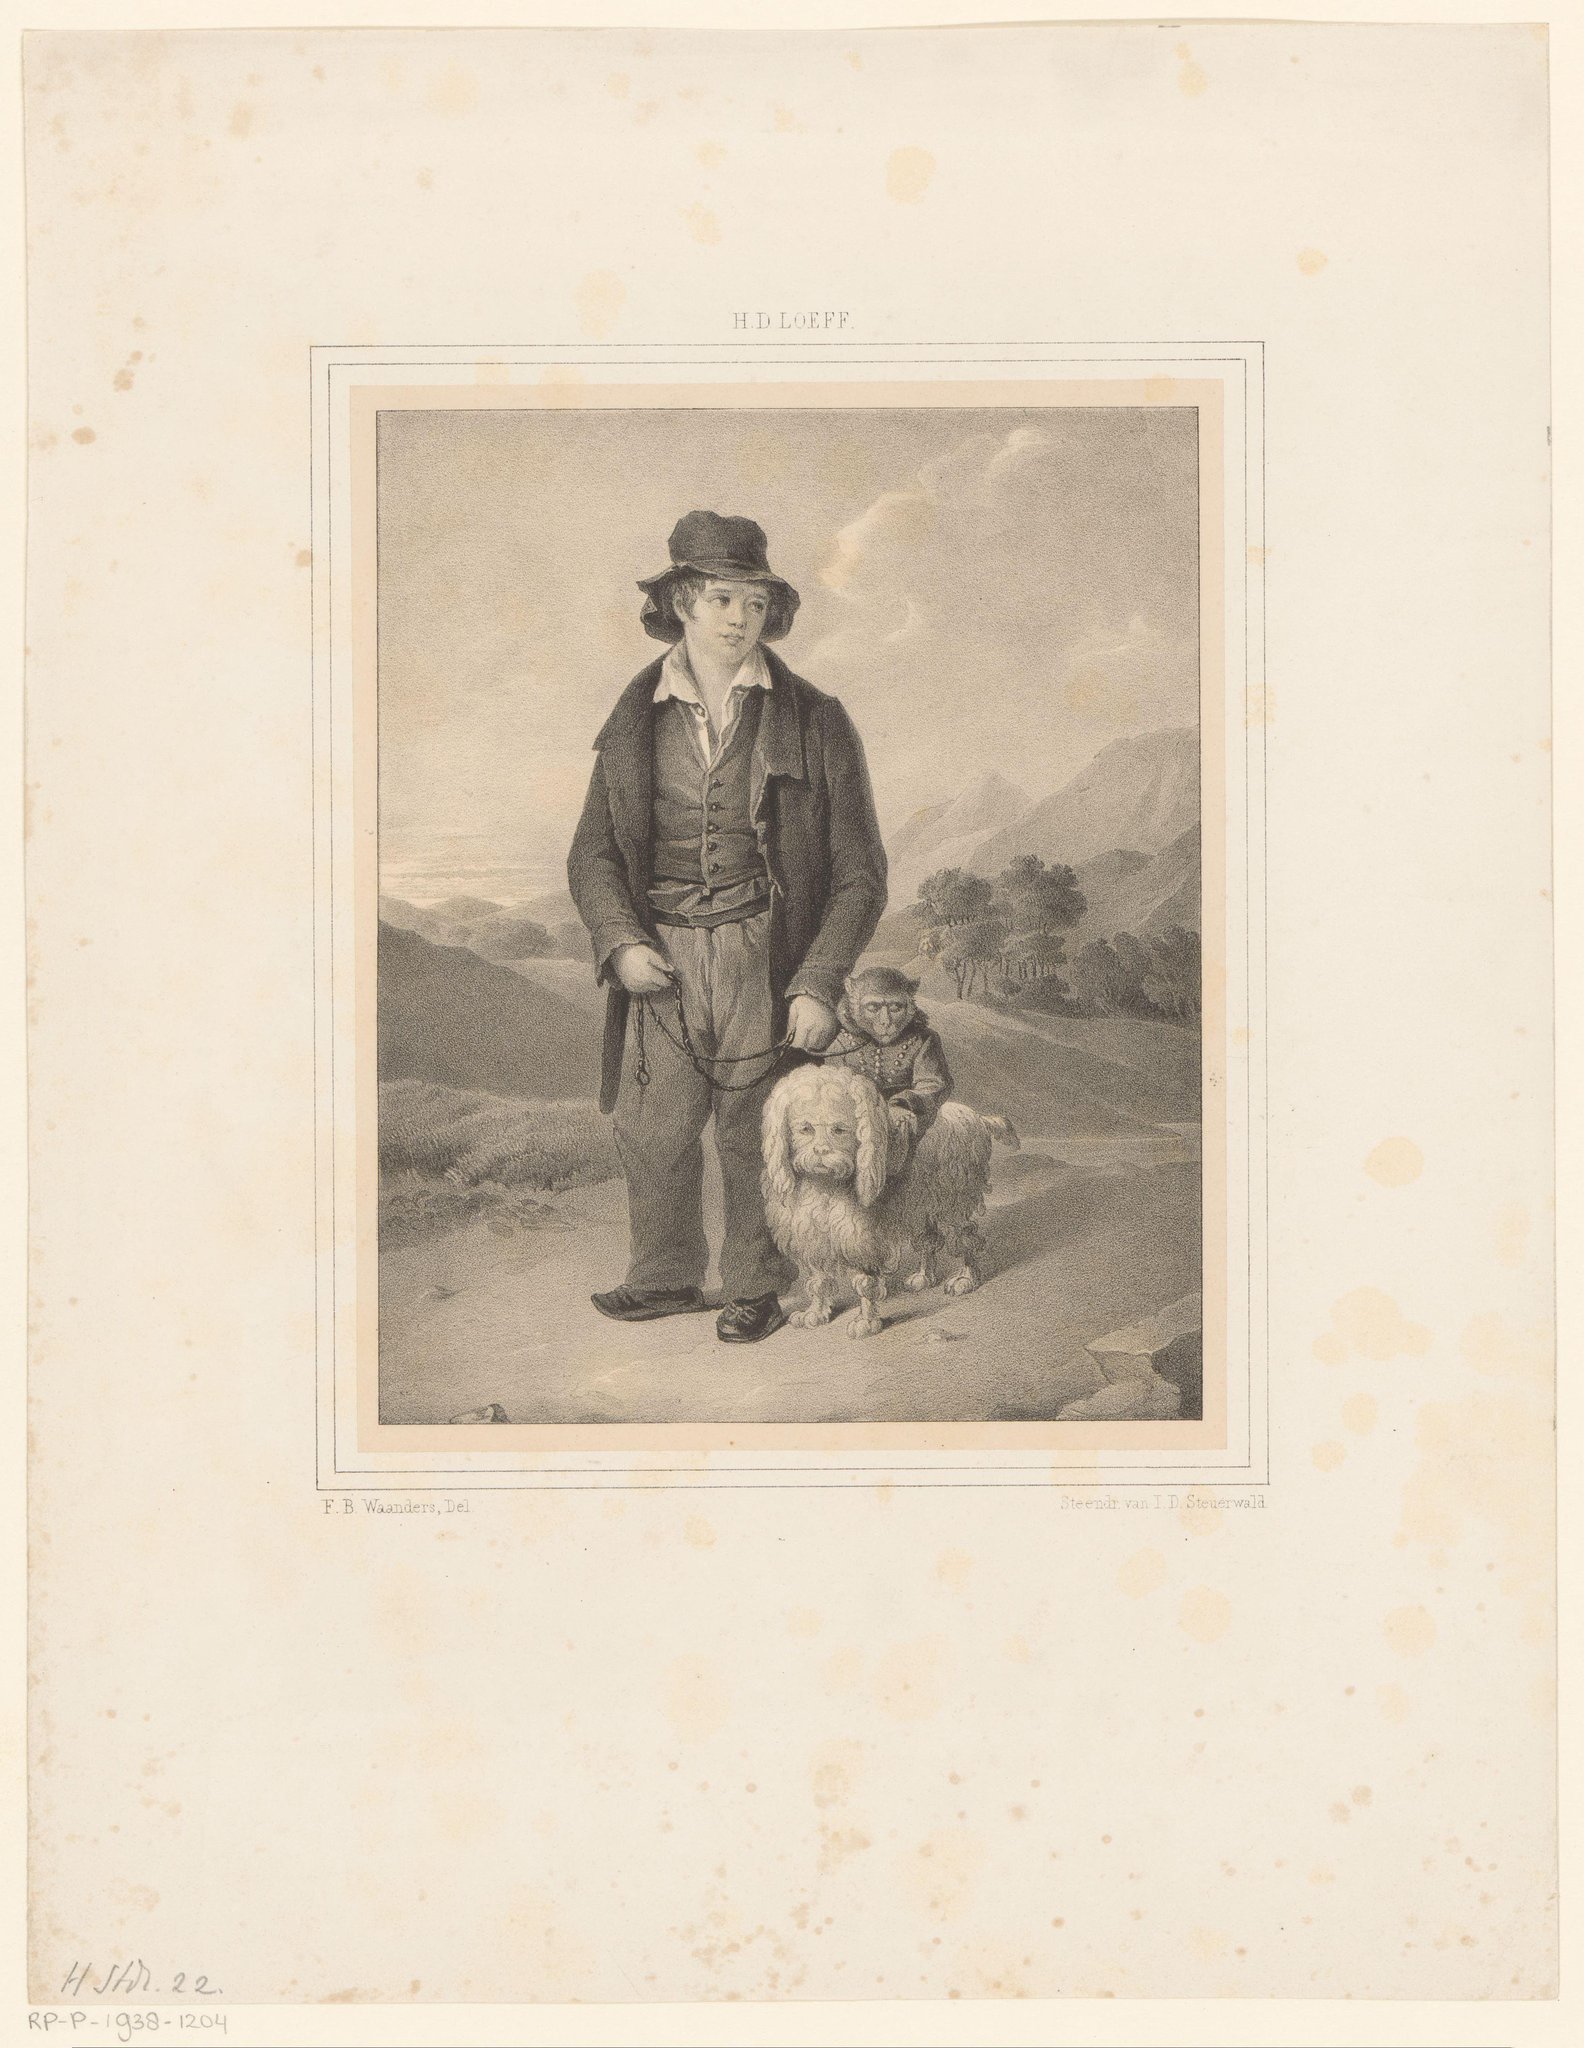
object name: print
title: Jongen met hond en aap in landschap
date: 1846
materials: paper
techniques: lithograph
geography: the hague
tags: monkeys, apes, dog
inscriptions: collector's mark: Lugt 2760, collector's mark: Lugt 2228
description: Een jongen loopt met een aap gezeten op de rug van een hond in een landschap.